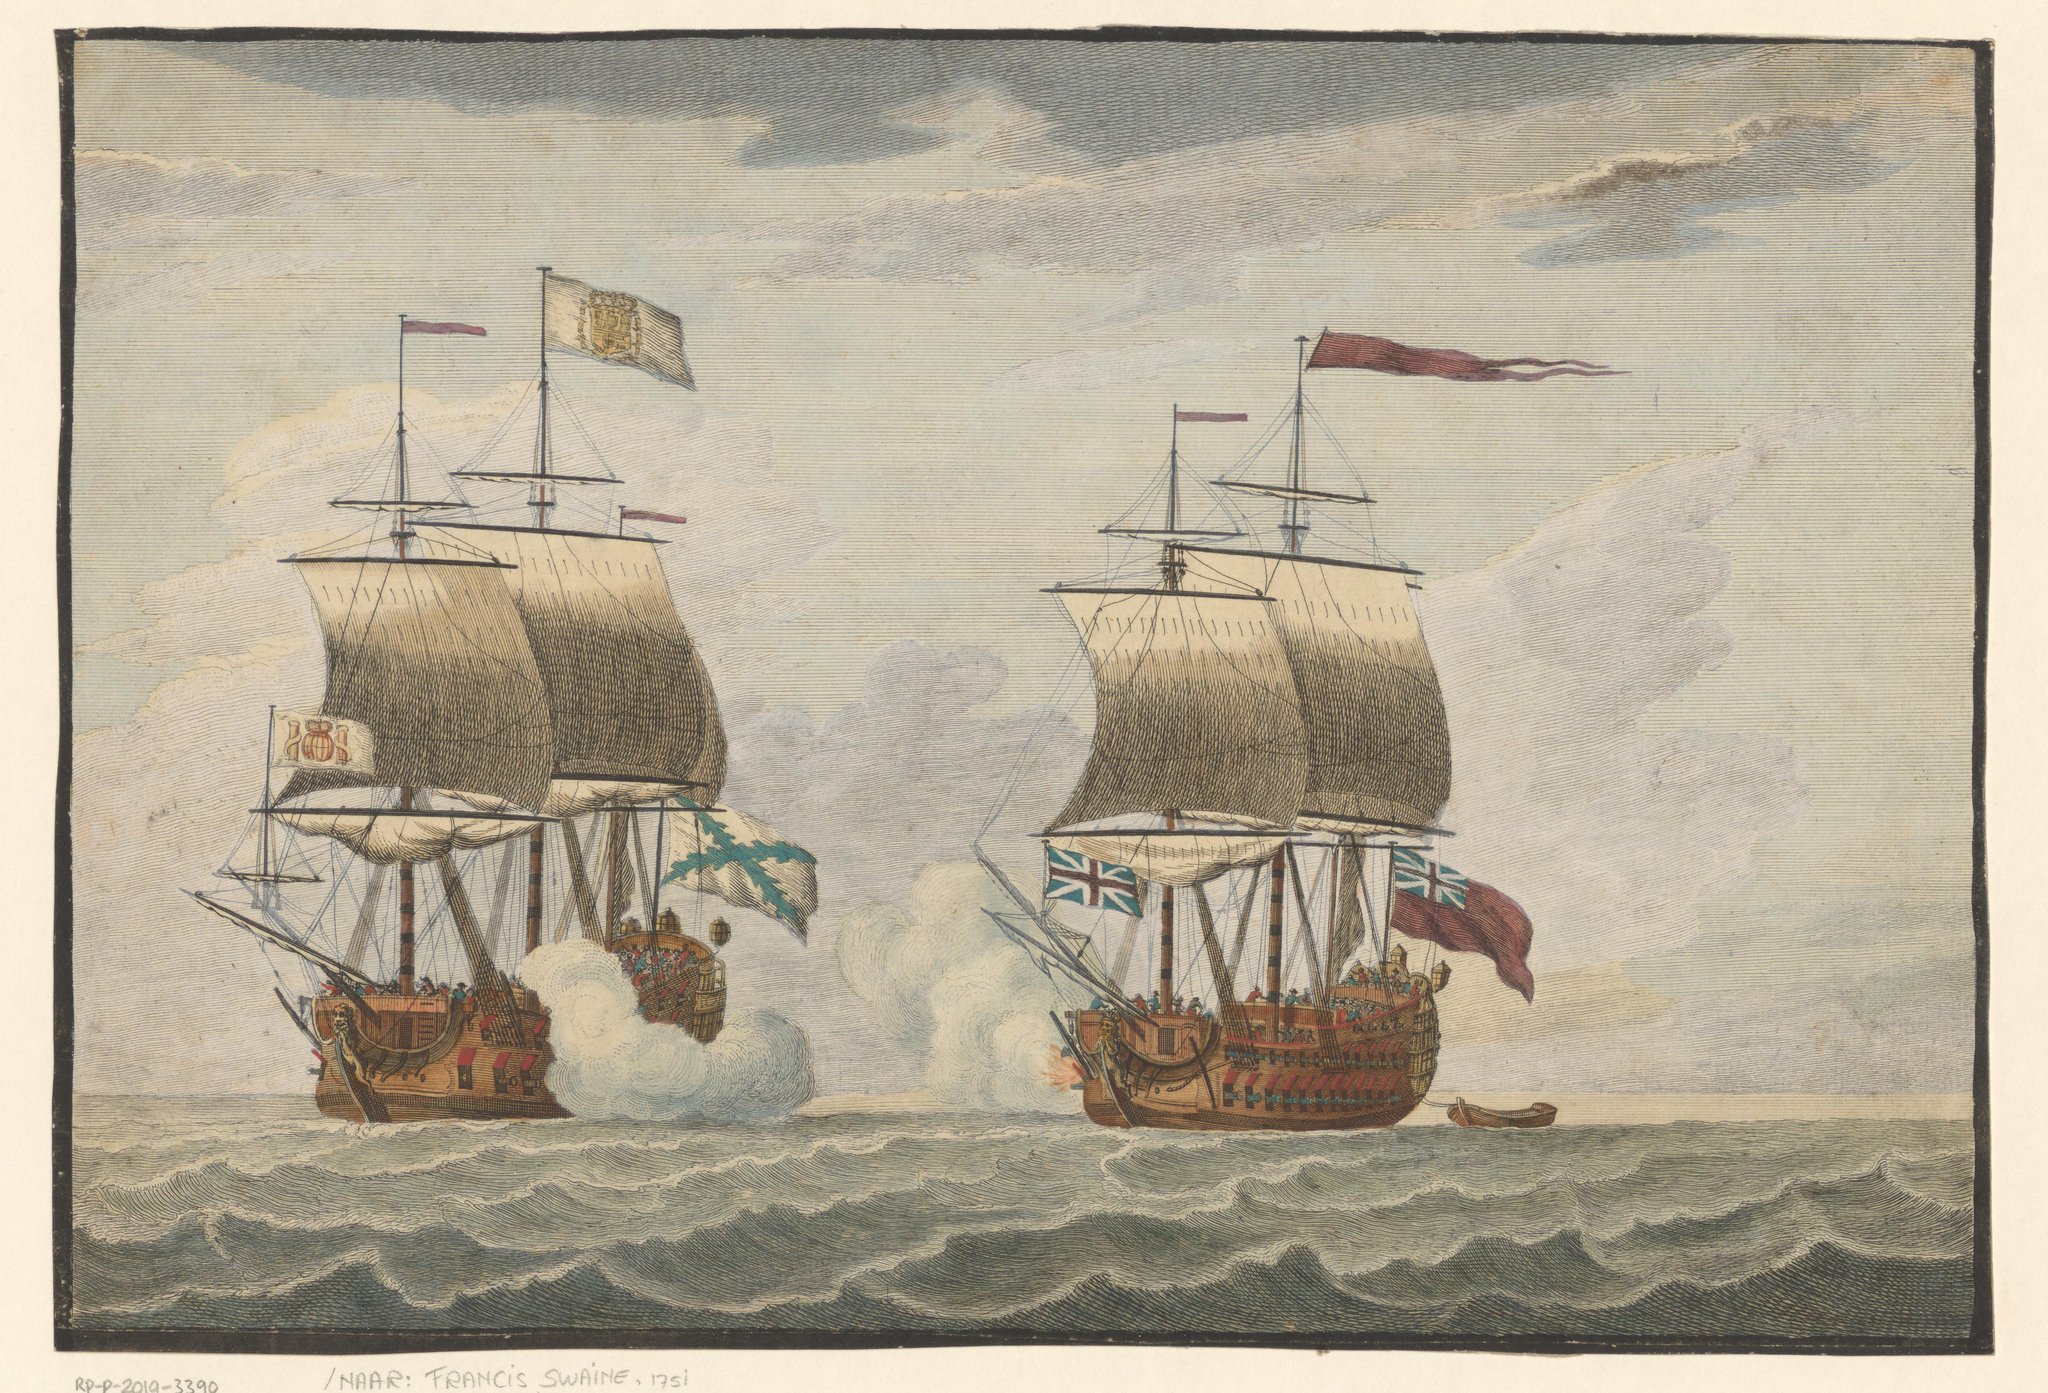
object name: print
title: George Anson op de Centurion schiet op het schip Nuestra Señora de Covadonga voor Manilla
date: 1705-1751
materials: cardboard, paper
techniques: etching, hand coloring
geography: great britain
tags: sailing-ship, sailing-boat, battle (+ naval force)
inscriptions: collector's mark: Lugt 2228